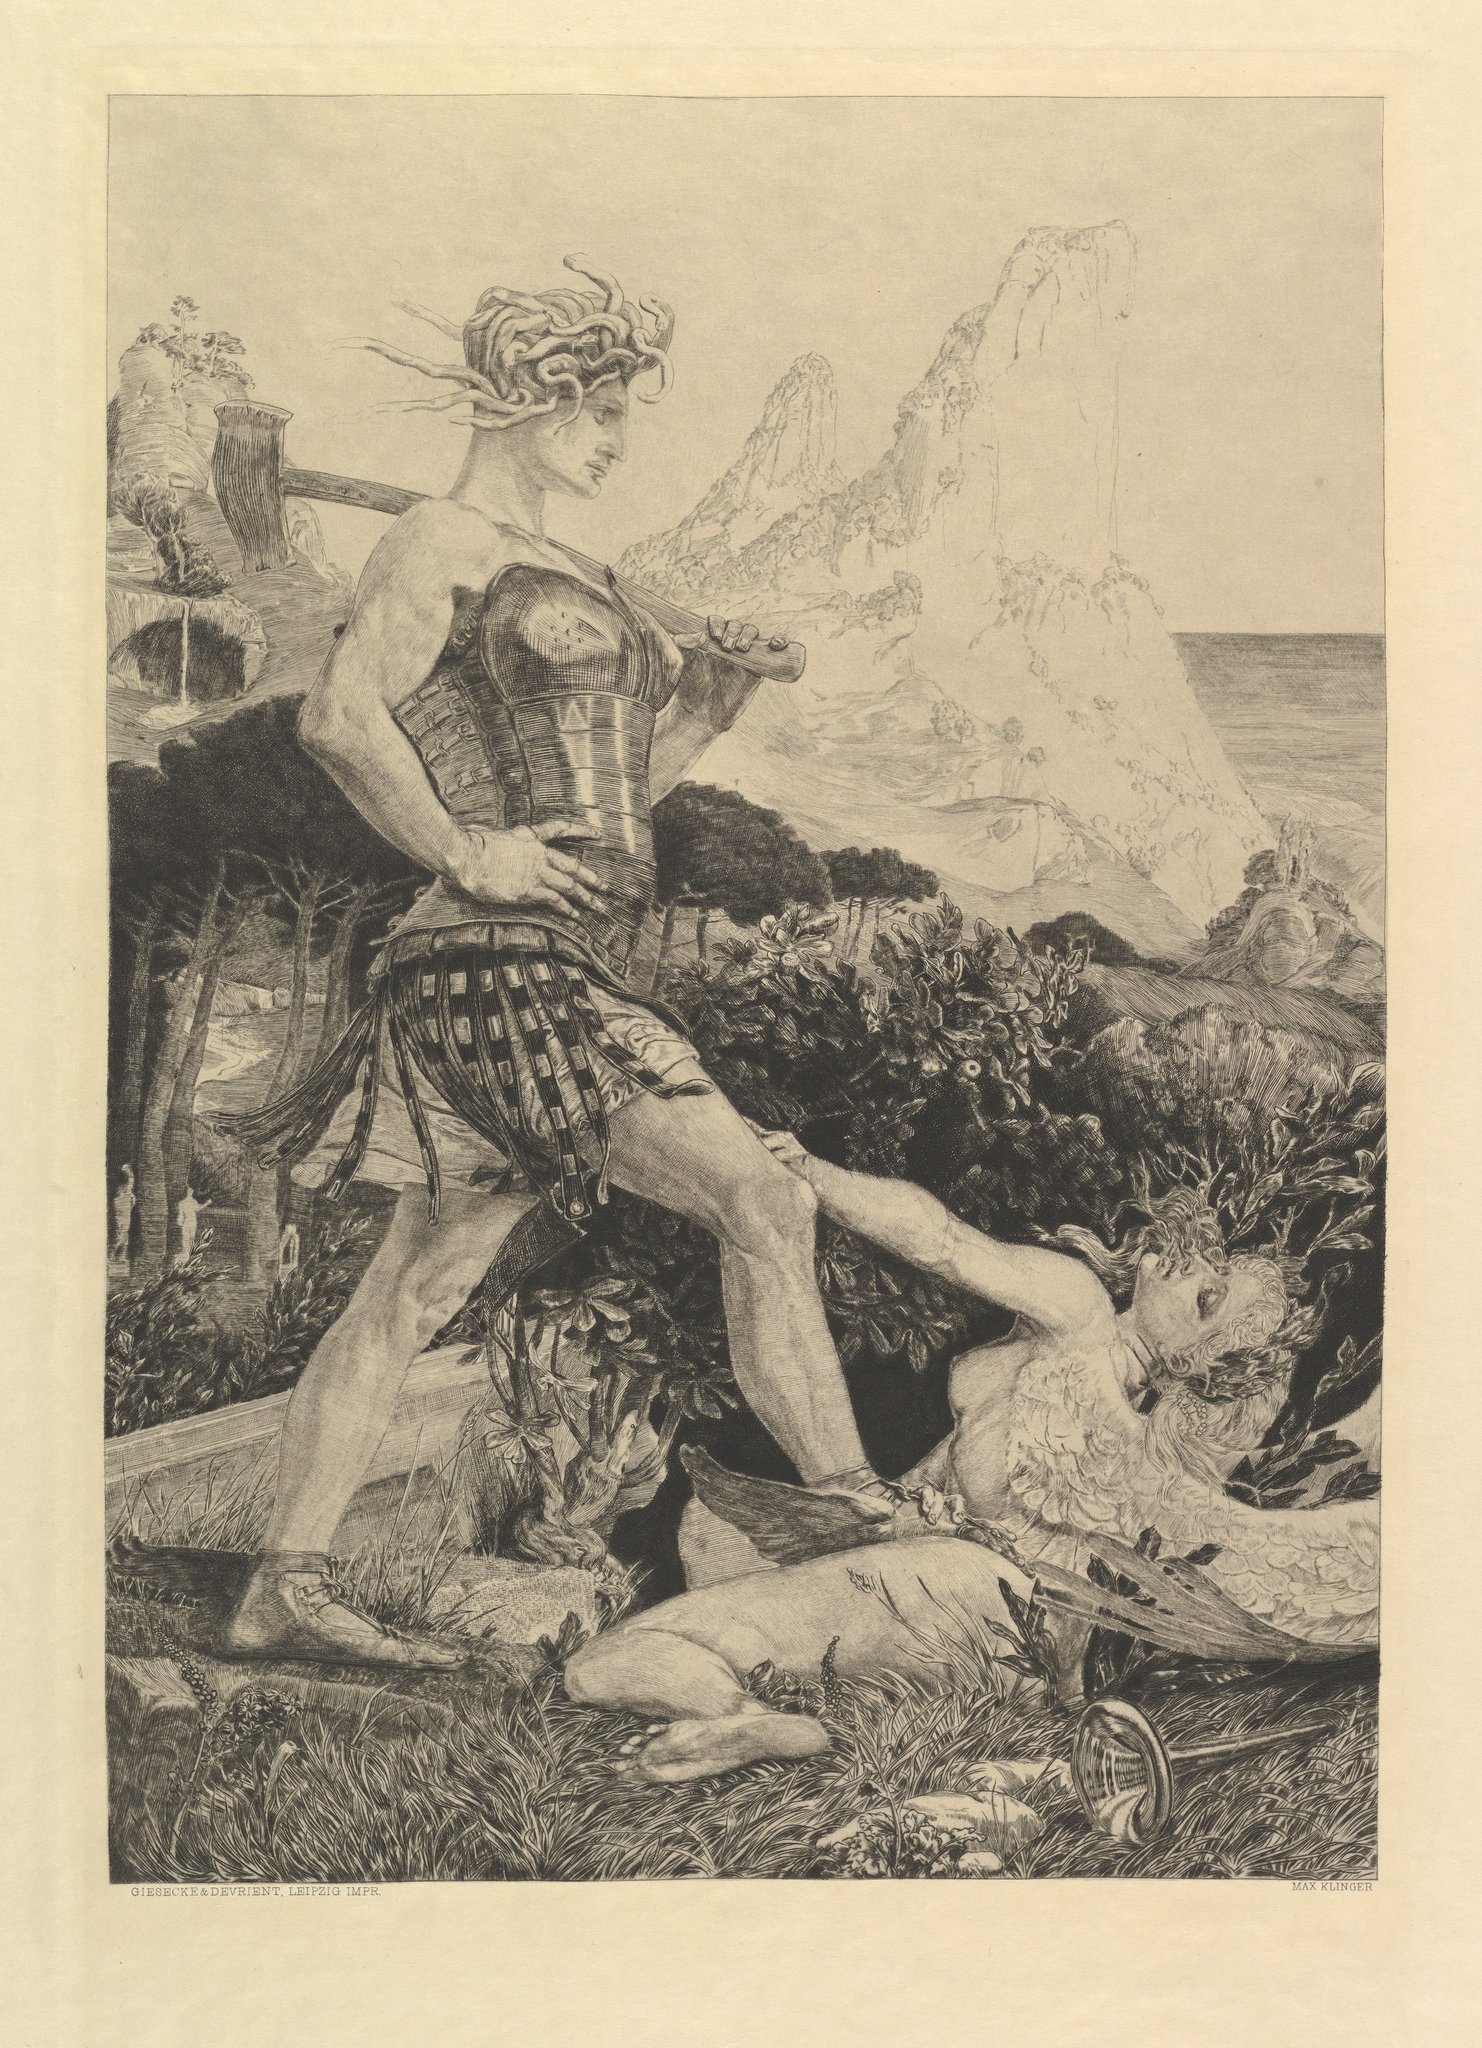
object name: print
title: Zeit und Ruhm, from the series Vom Tode Zweiter Teil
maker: max klinger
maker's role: artist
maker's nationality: german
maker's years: 1857-1920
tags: women